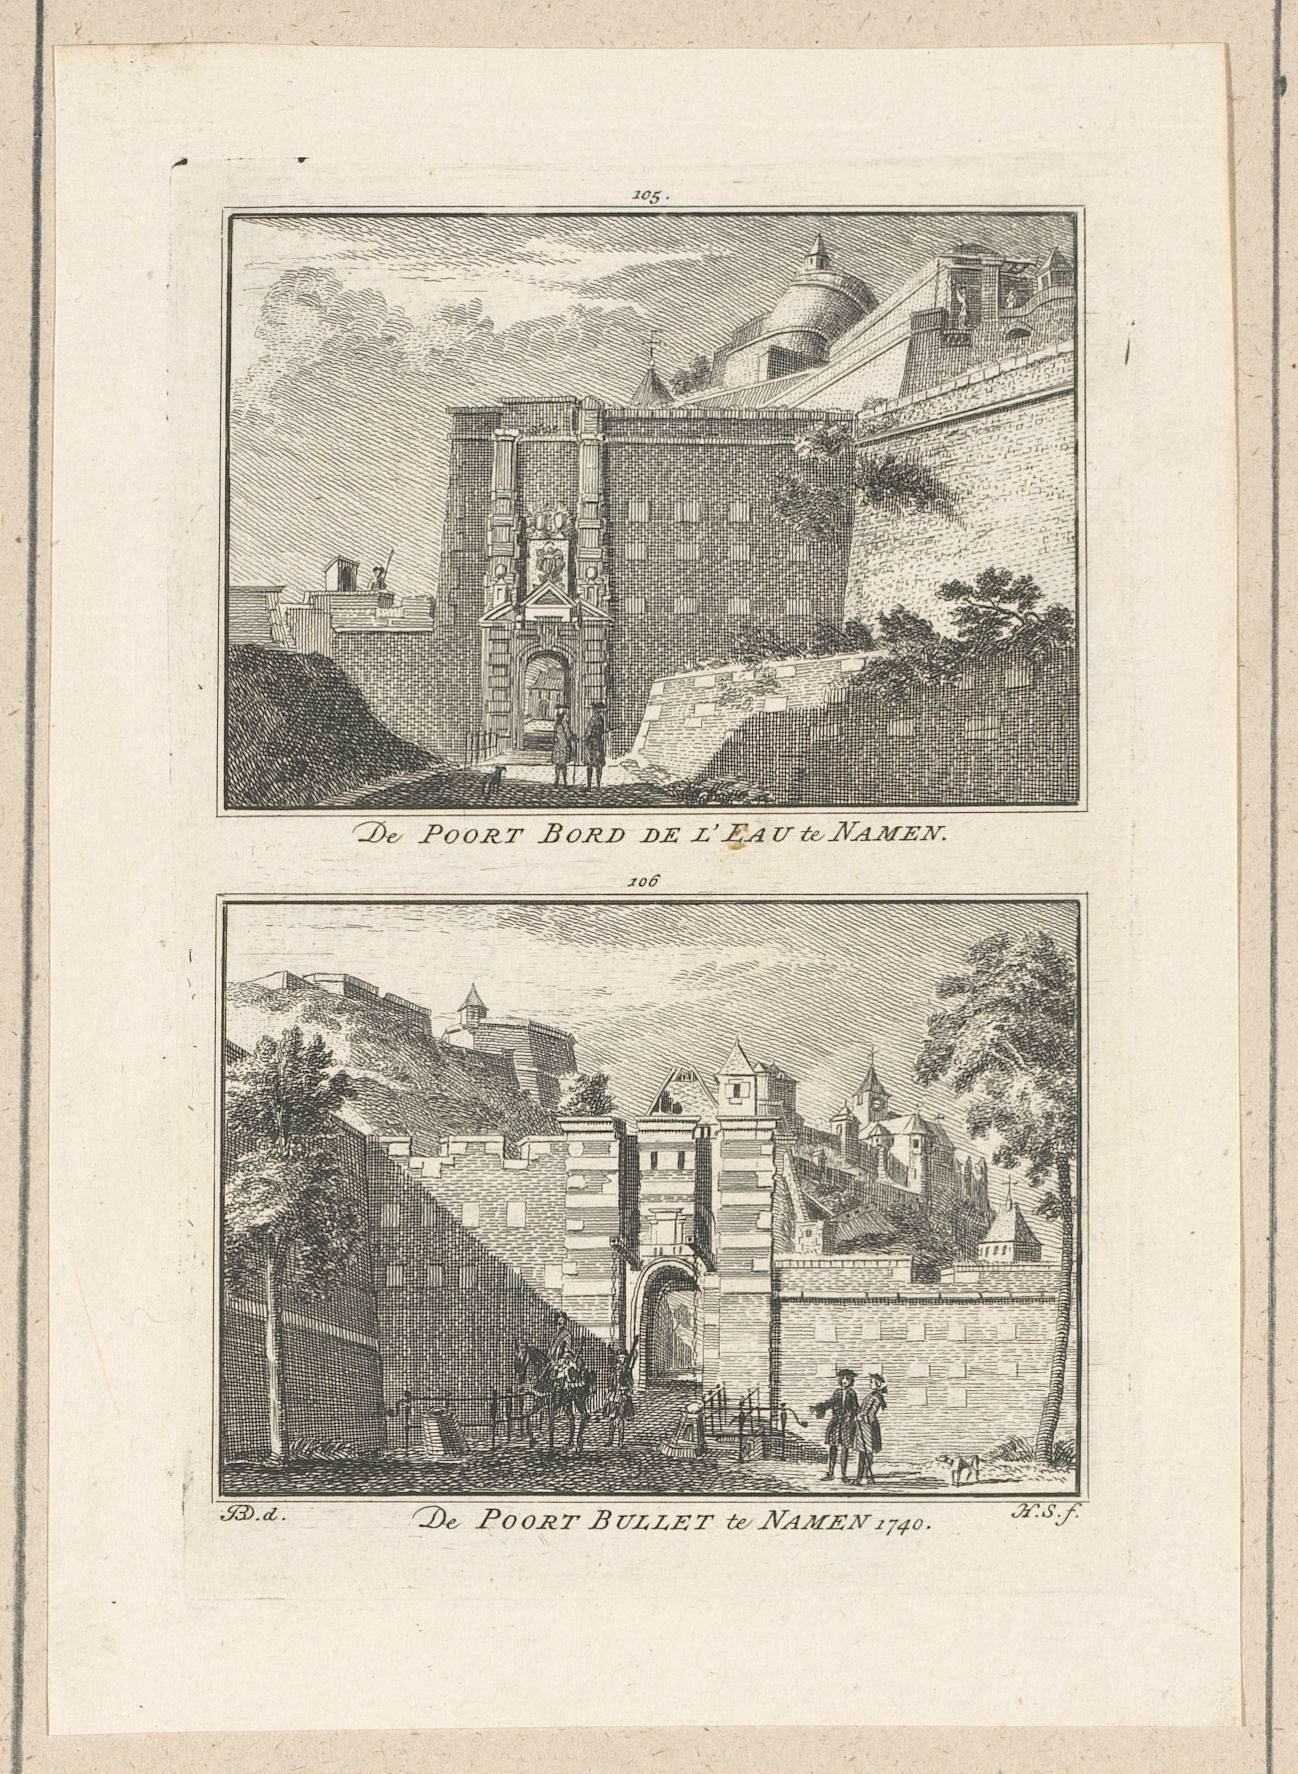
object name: print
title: Gezicht op de poort Bord de l'Eau en gezicht op de poort Bullet, te Namen, 1740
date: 1746-1792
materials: paper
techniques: engraving, etching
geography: haarlem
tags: city-gate, prospect of city, town panorama, silhouette of city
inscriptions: collector's mark: Lugt 2228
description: Prent ook gebruikt in: Het verheerlykt Nederland of kabinet van hedendaagsche gezigten van steden, dorpen (…). 9 delen. Amsterdam: Isaak Tirion en weduwe Isaak Tirion, 1745-1774, dl. 2 (1746), ill. 105-106. Of in: Nederlandsche tafereelen; of eene keurige verzameling van negen honderd fraaije gezigten van steden, dorpen, sloten, oudheden (…). 9 delen. Amsterdam: Jan de Groot, 1792, dl. 2, ill. 105-106.